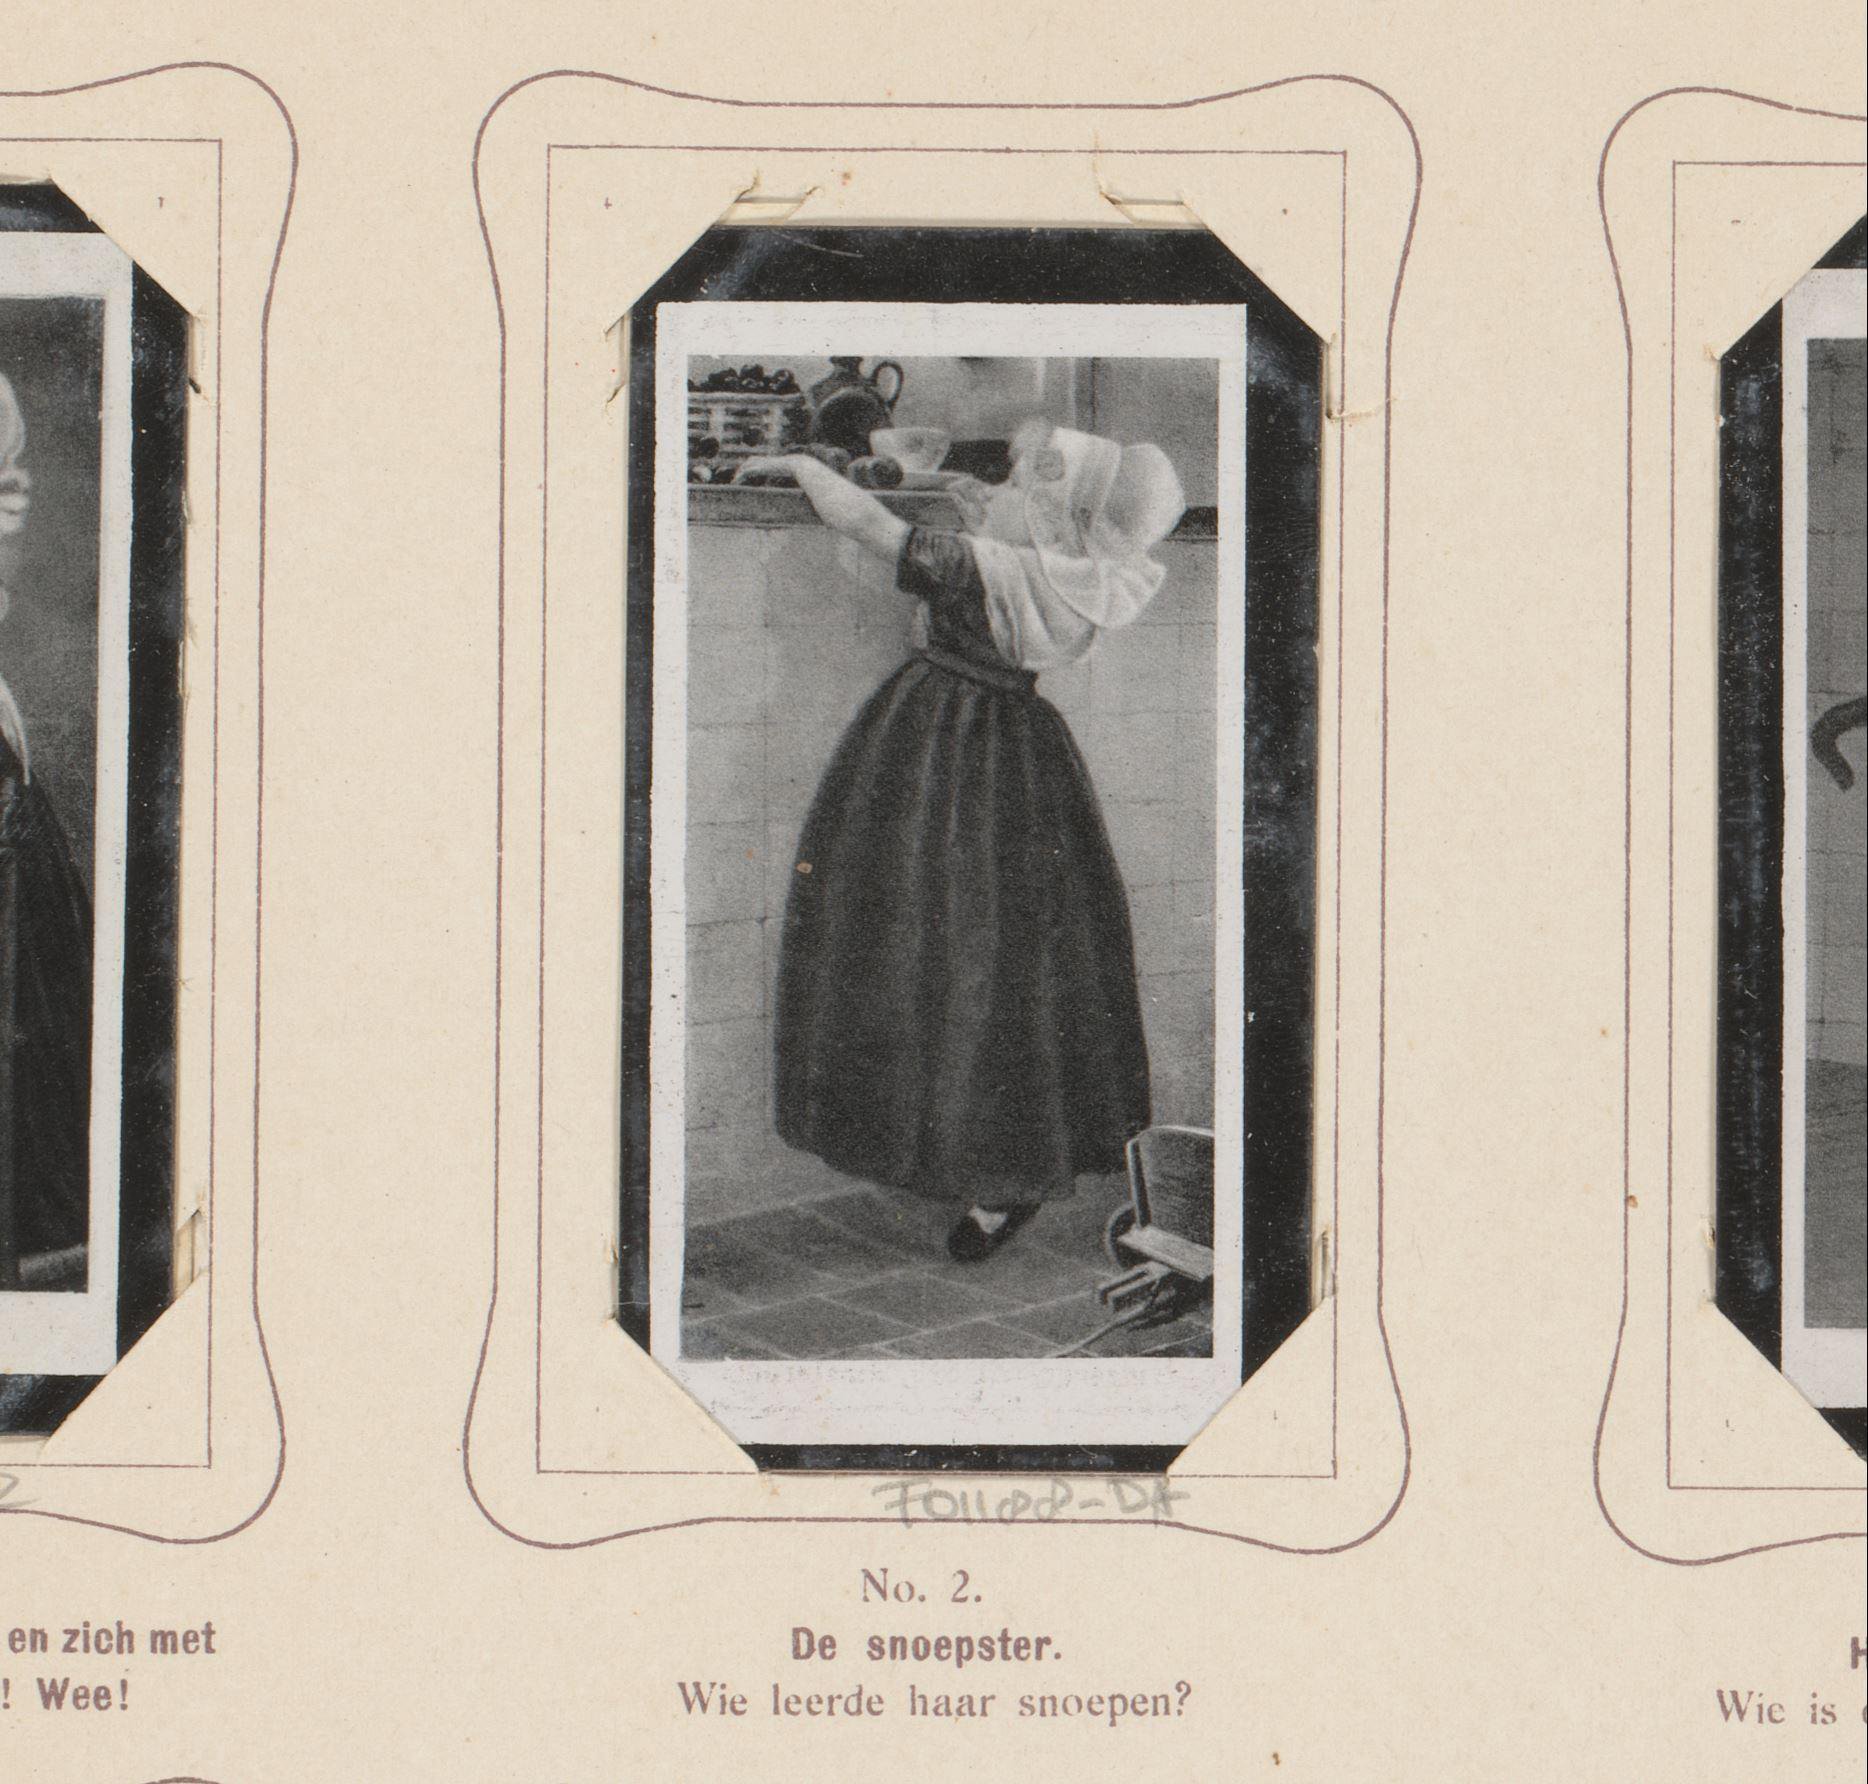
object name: photomechanical print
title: Meisje pakt snoep van het aanrecht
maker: Anonymous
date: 1906-1907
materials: paper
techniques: photograph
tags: girl (child between toddler and youth), sugar-candy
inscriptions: inscription: ‘No. 2./ De snoepster./ Wie leerde haar snoepen?’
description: Deze prent maakt deel uit van een album.